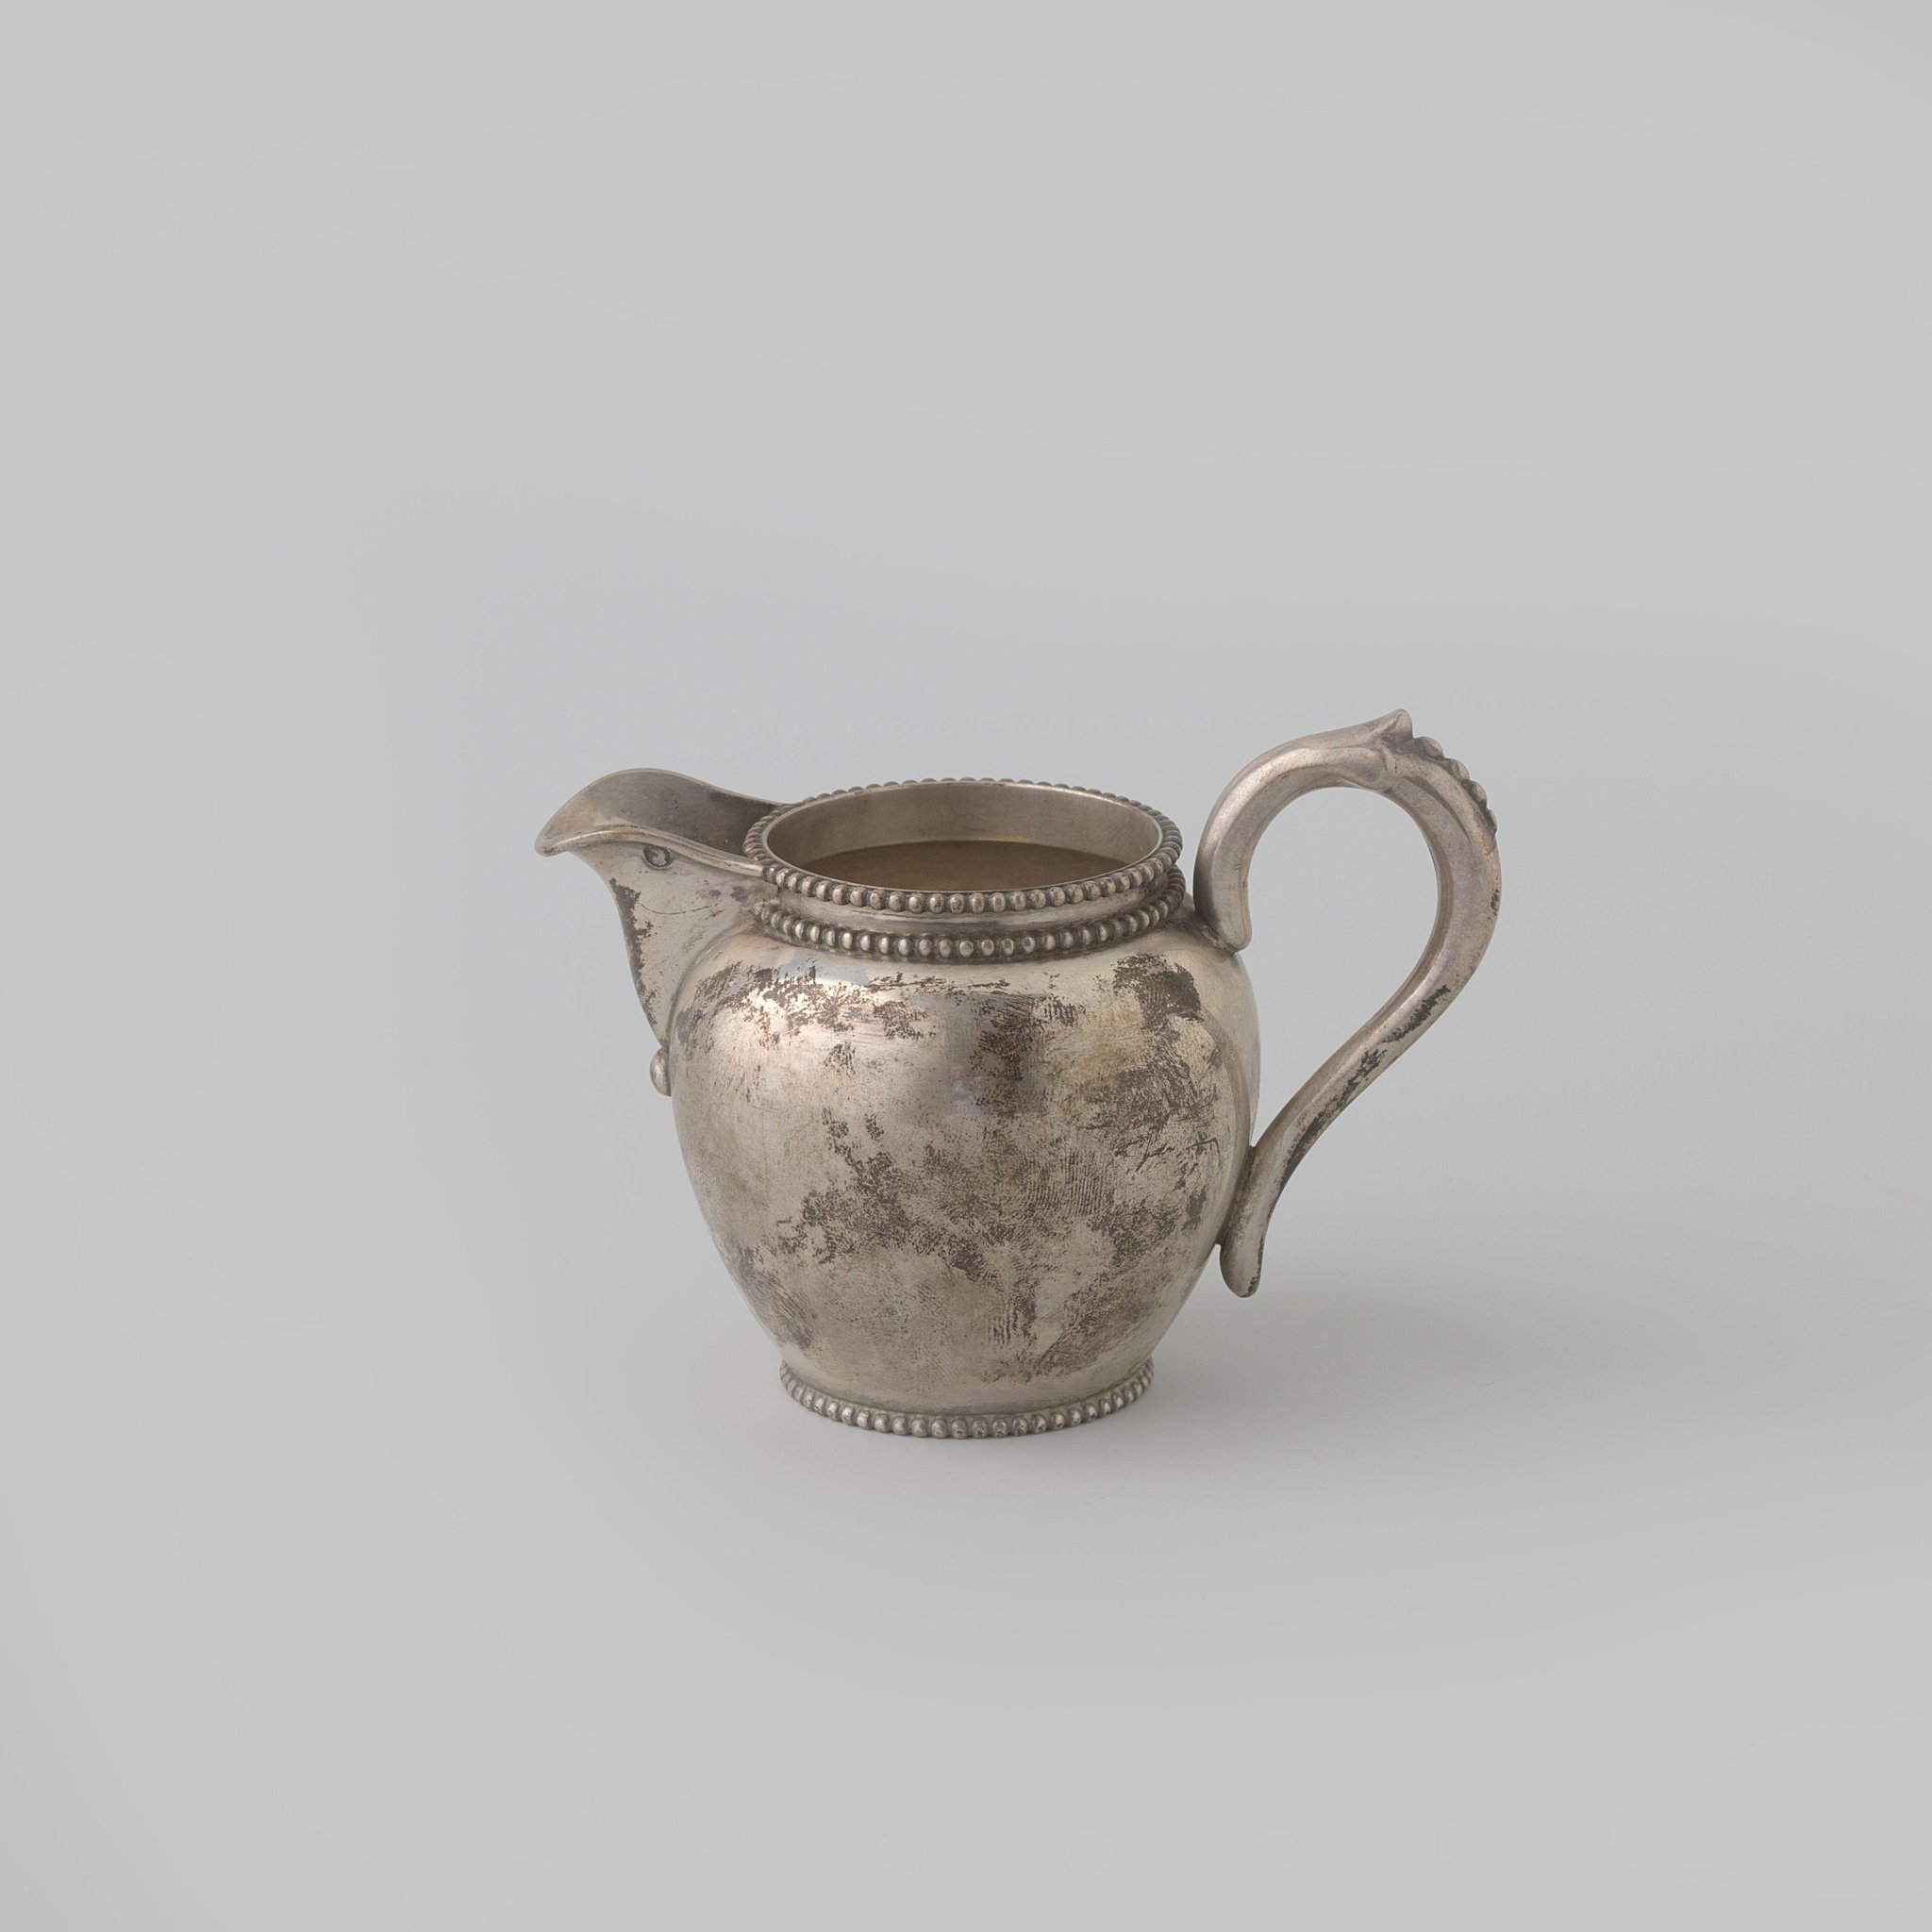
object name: milk jug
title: Melkkan, gestrekt bolvormig en afgezet met parelranden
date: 1892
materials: silver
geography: voorschoten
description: Melkkan van zilver. Gestrekt bolvormig en afgezet met parelranden.